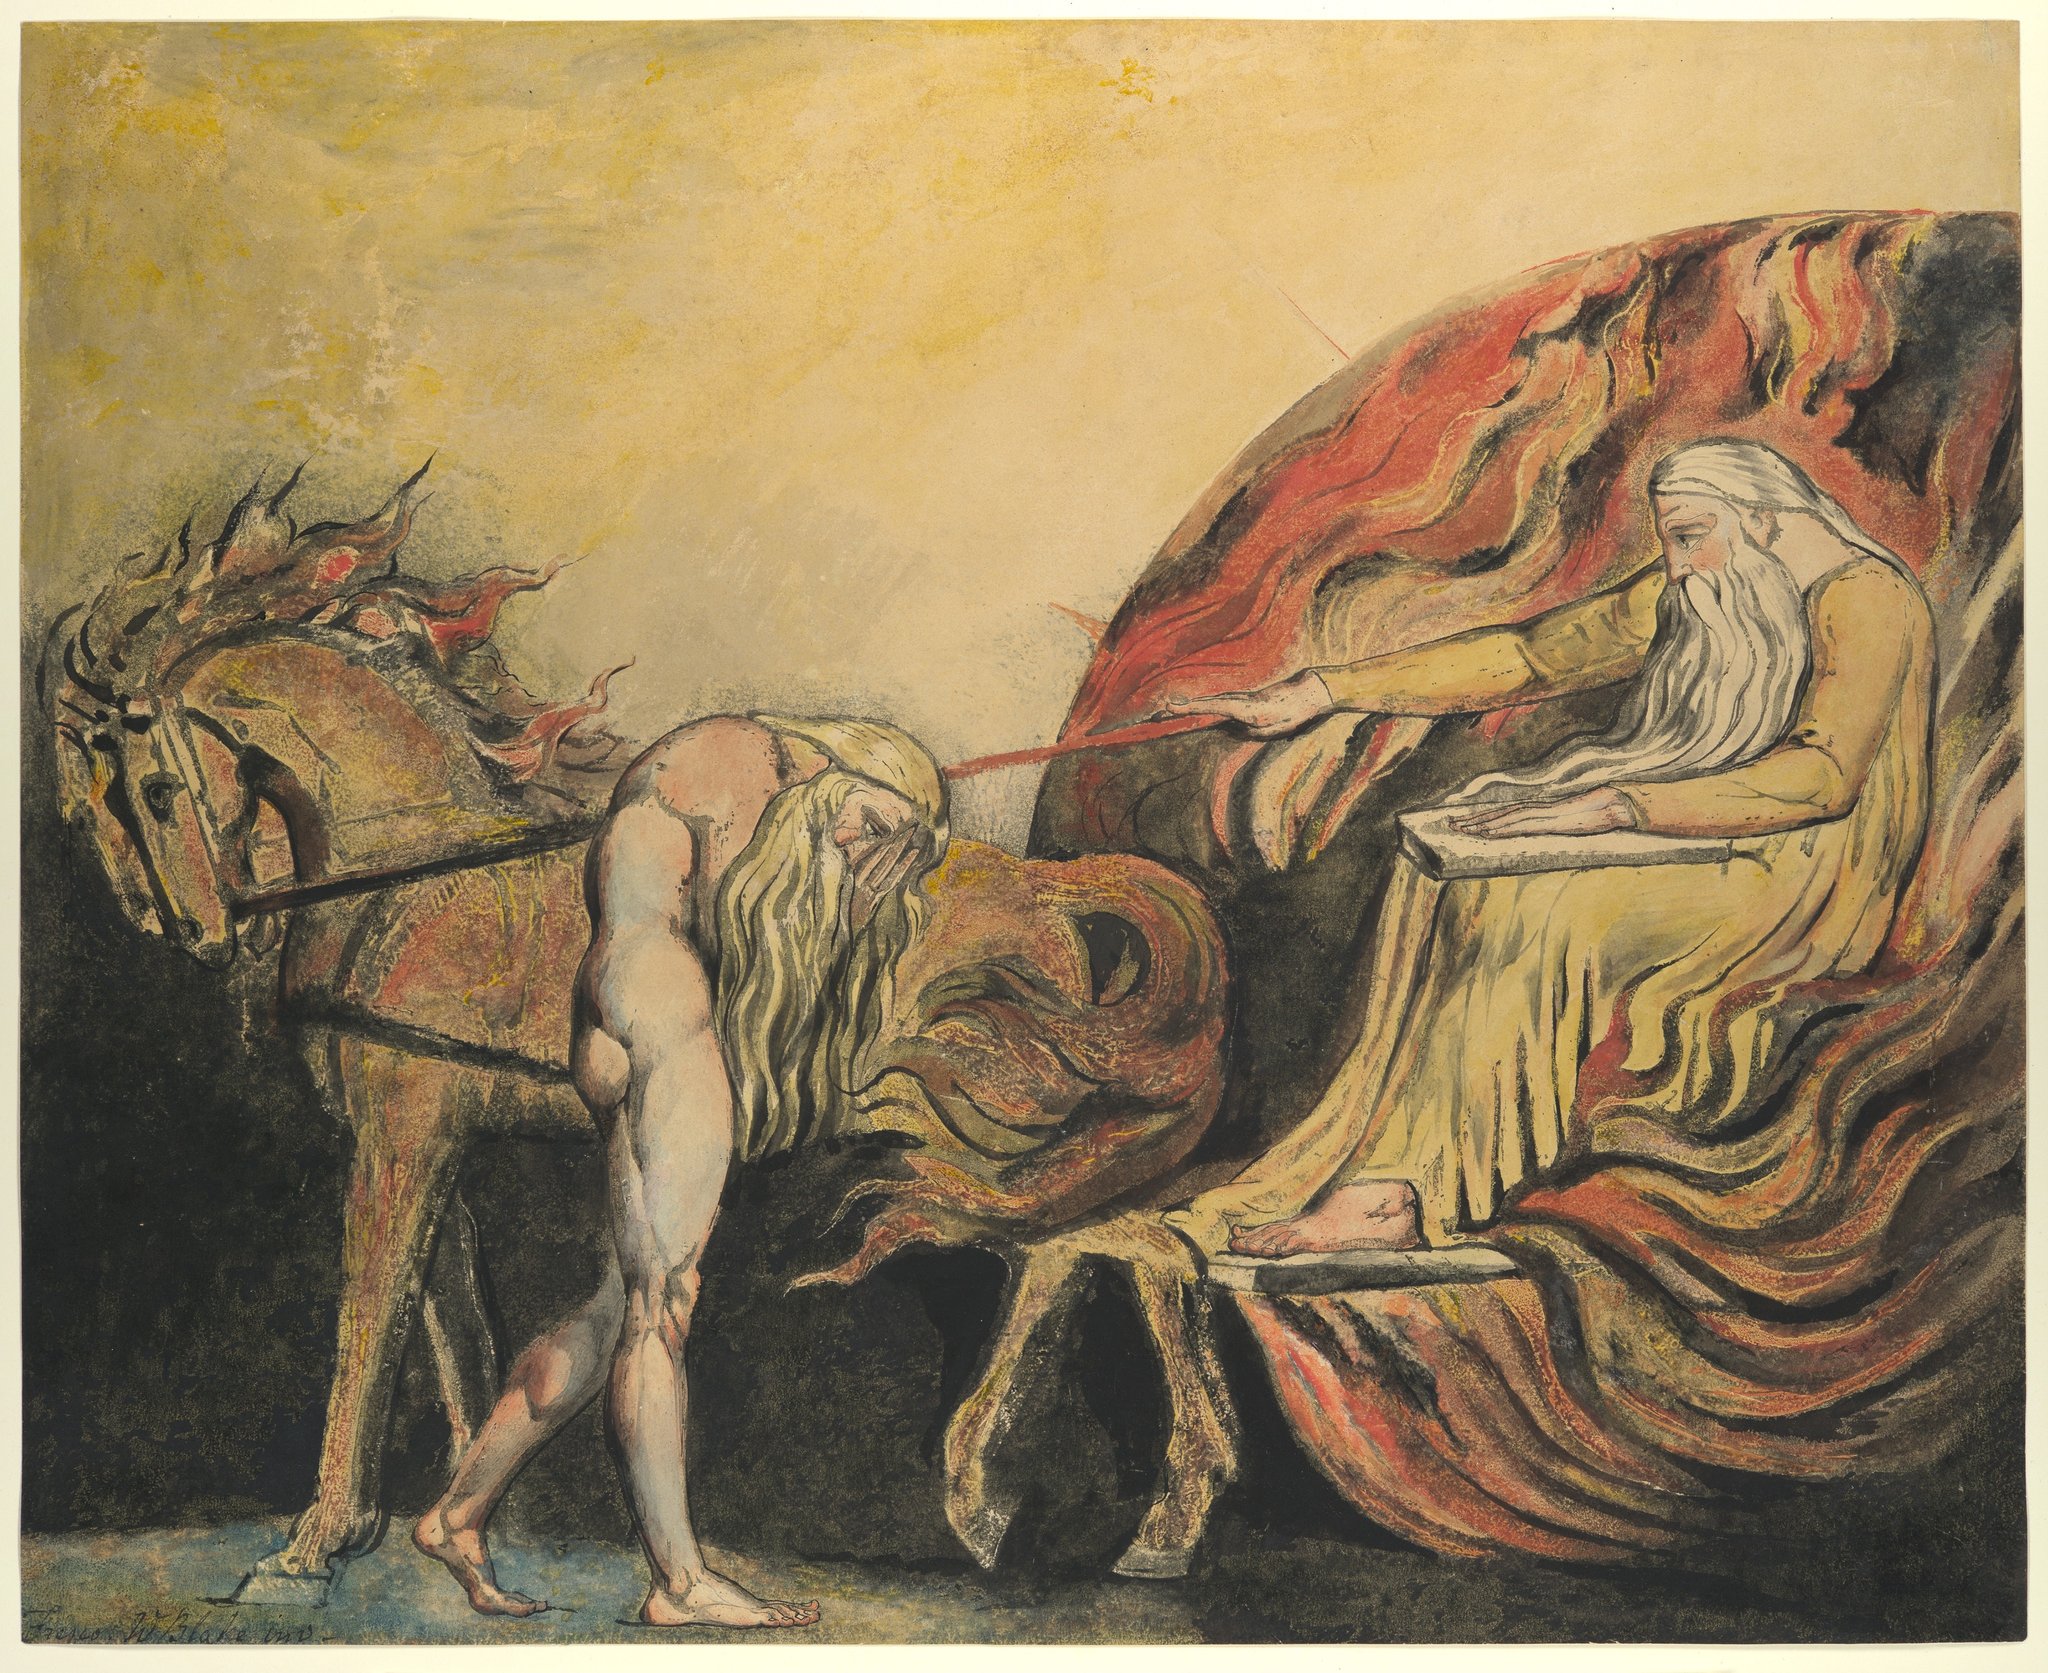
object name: print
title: God Judging Adam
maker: william blake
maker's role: artist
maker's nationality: british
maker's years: 1757-1827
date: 1795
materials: ink, watercolor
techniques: etching, pen, relief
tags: horses,adam,chariots,god the father